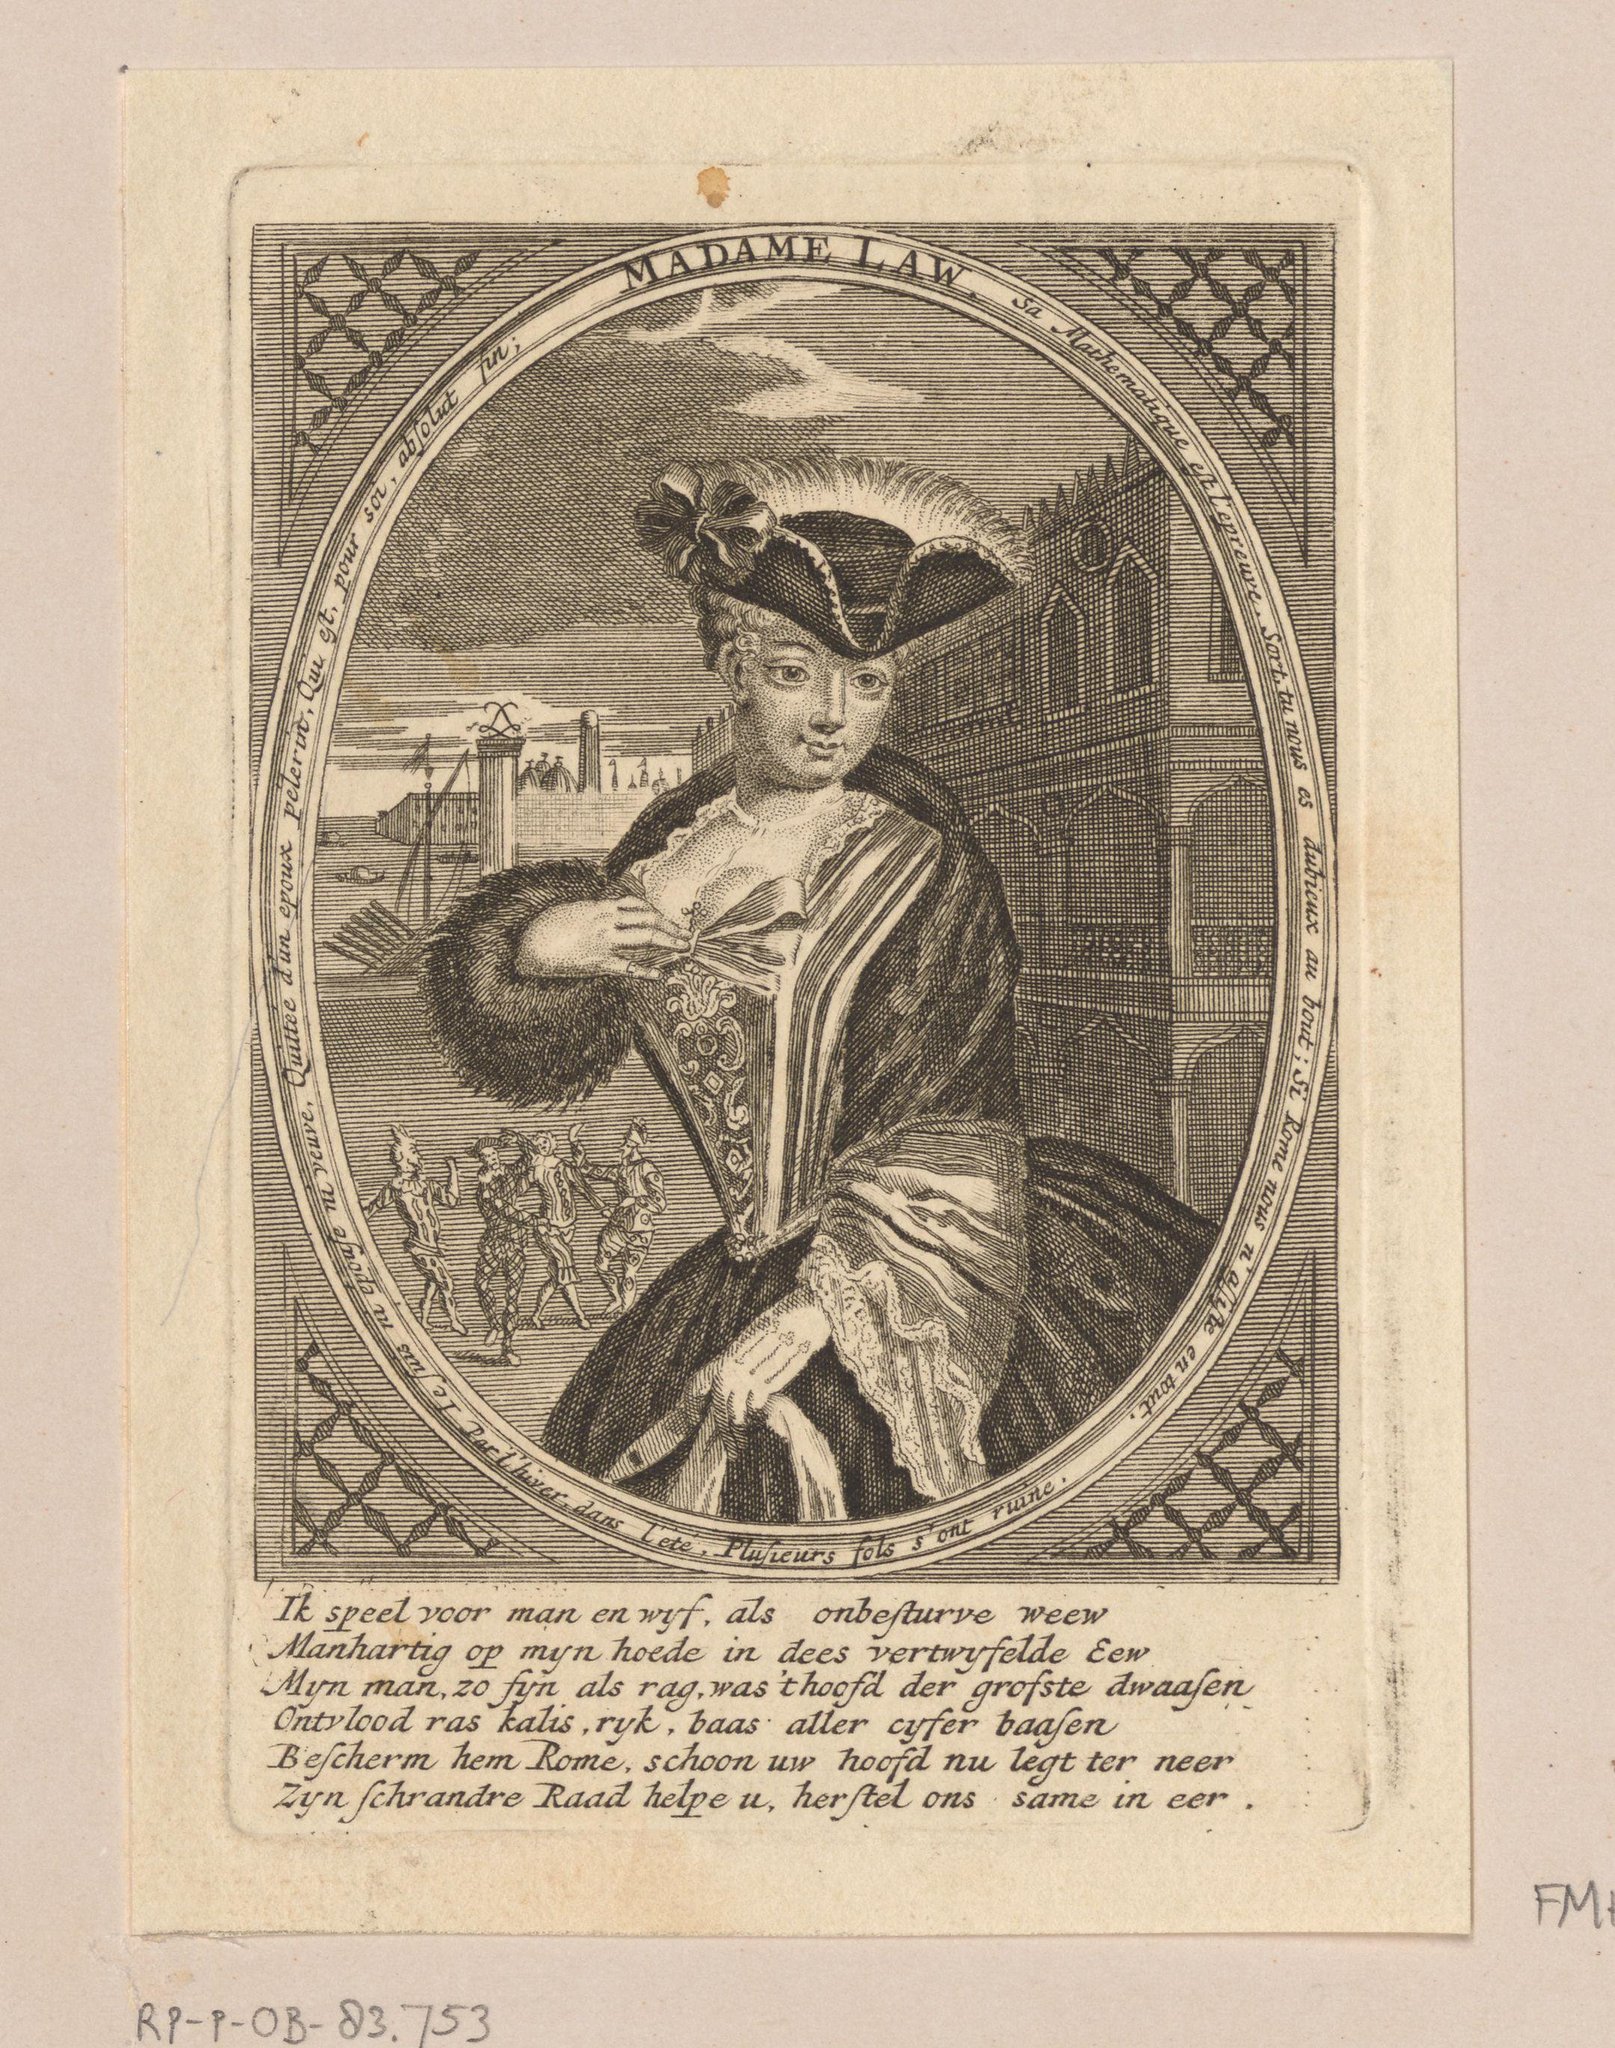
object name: book illustration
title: Portret van Madame Law, ca. 1720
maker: claude duflos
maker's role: print maker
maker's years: 1665-1727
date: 1720-1722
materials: paper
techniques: etching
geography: france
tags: historical persons - bb - woman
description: Ovaal portret van madame Law, ca. 1720. Halffiguur staande voor het Sint-Marcoplein in Venetië, in de verte enkele dansende carnavalsvierders. Met randschrift in het Frans en onder het portret een zesregelig vers in het Nederlands. Behoort tot de groep van prenten toegevoegd aan de serie Tafereel der Dwaasheid met spotprenten op de Windhandel of Actiehandel van 1720.